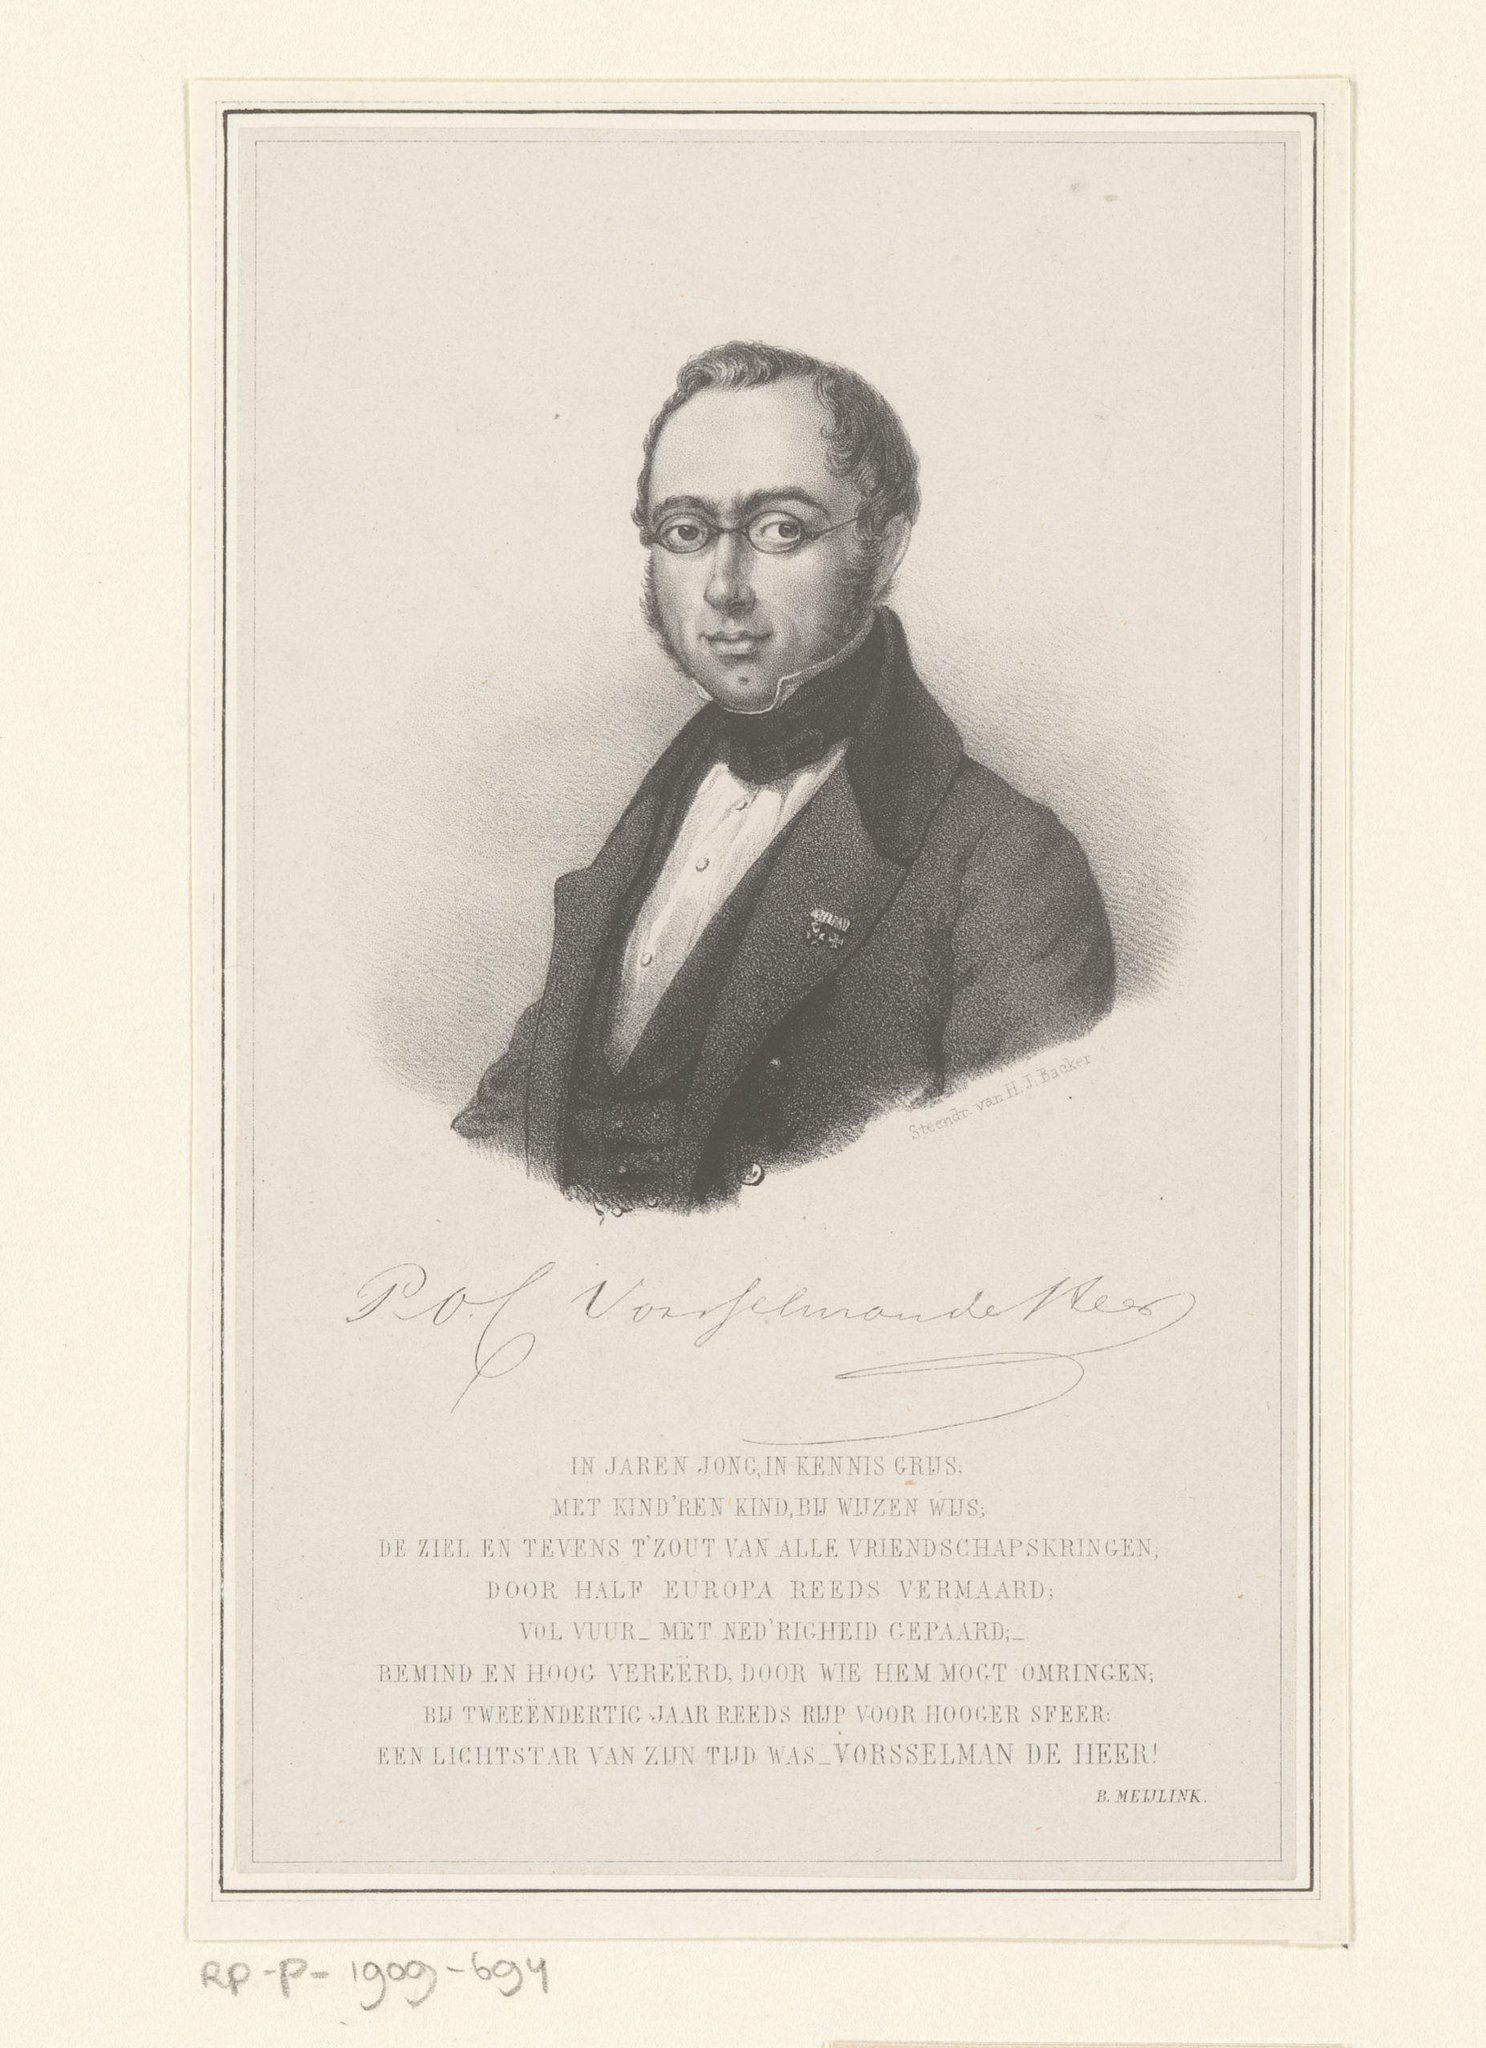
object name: print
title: Portret van professor Pieter Otto Coenraad Vorsselman de Heer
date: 1822-1845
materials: paper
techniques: lithograph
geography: dordrecht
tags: utrecht, physicist, eyeglasses, spectacles, knighthood order, historical persons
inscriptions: collector's mark: Lugt 2228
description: De geportretteerde draagt een bril en een ridderorde. Onder het portret zijn signatuur en enkele versregels door B. Meijlink